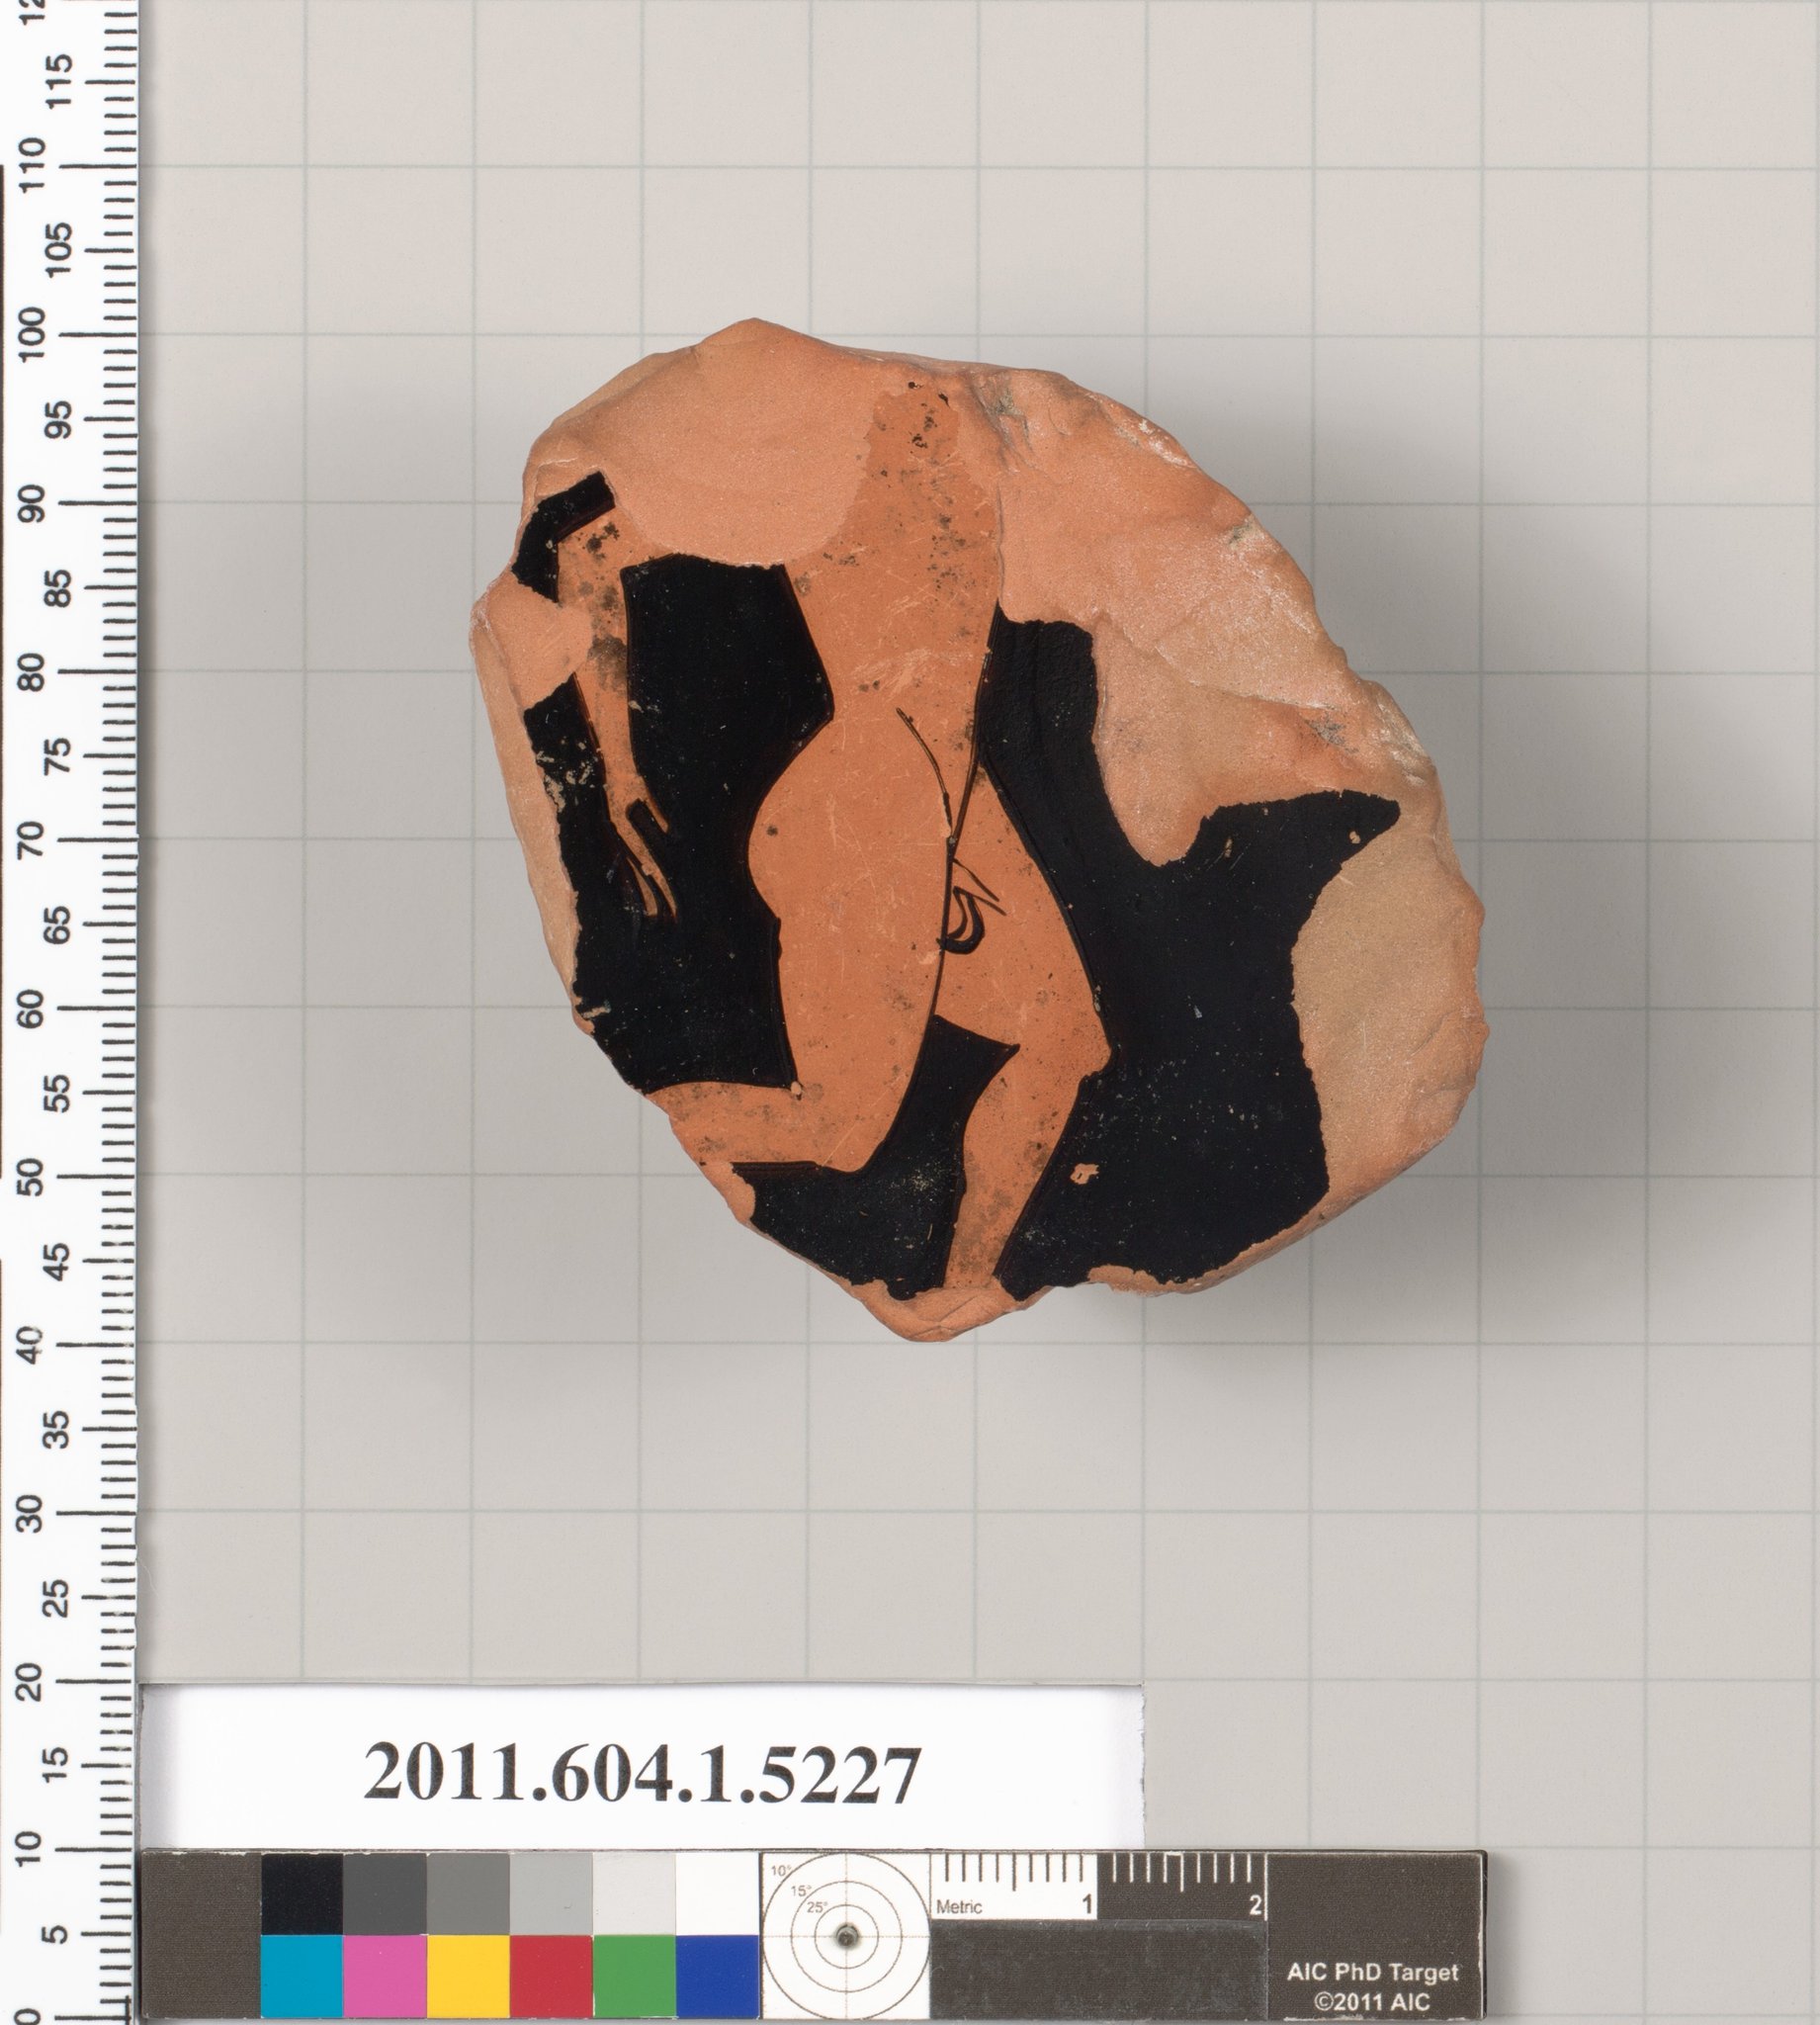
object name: kylix fragment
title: Terracotta fragment of a kylix (drinking cup)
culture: greek, attic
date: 520-500 BCE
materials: terracotta